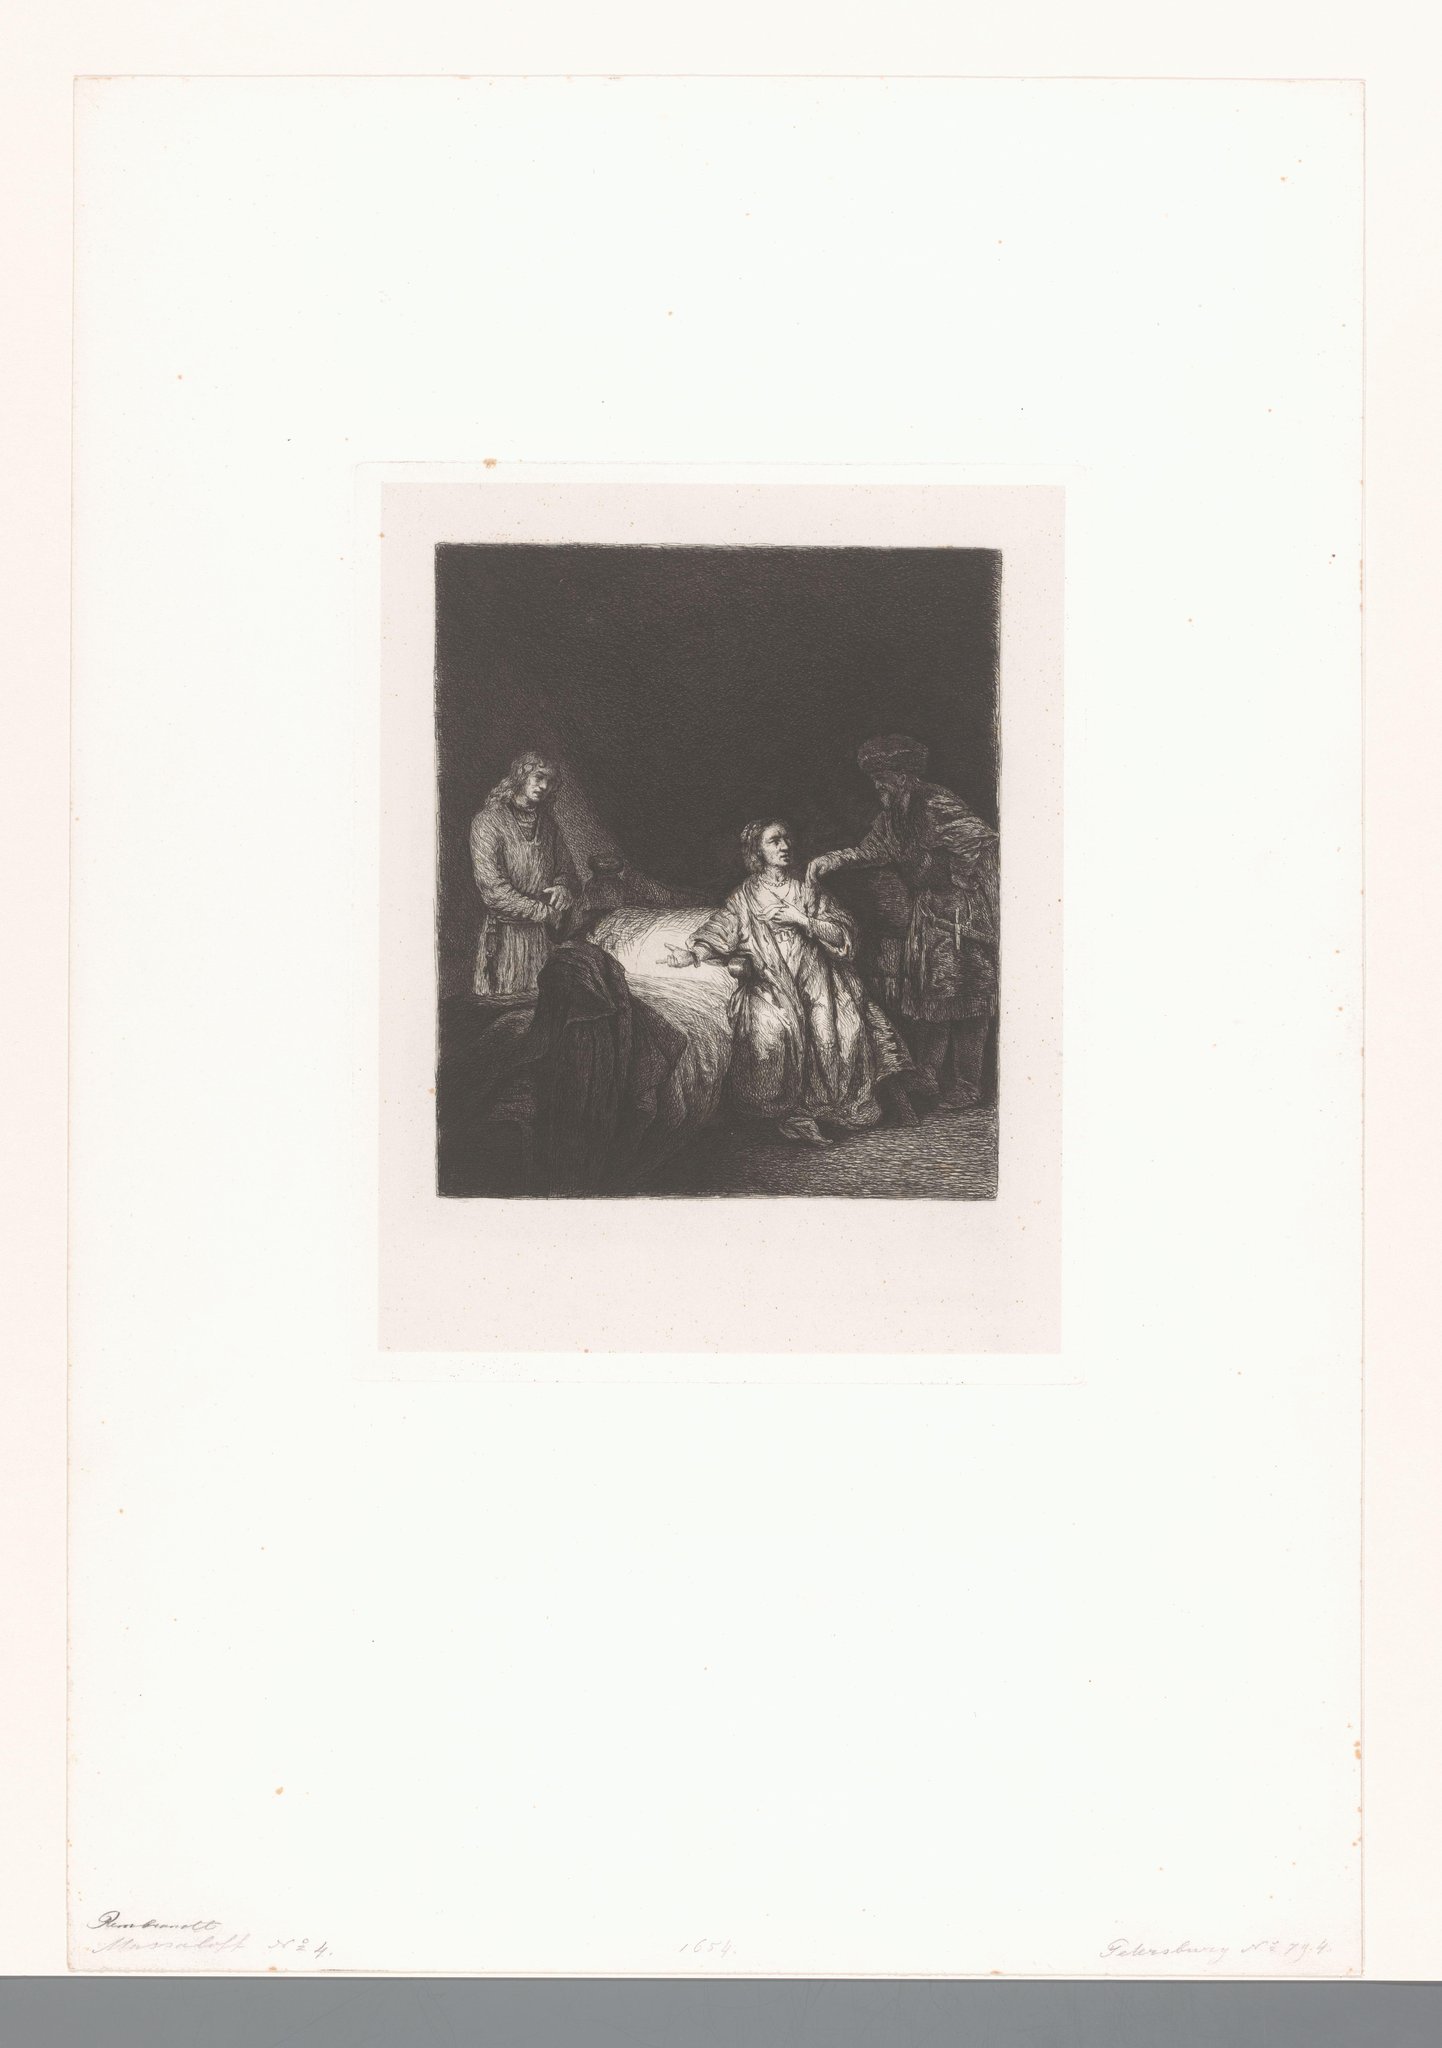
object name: print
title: Jonge vrouw wijst oude man op bed, waar een jonge man achter staat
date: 1857-1914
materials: paper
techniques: drypoint, etching, intaglio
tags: bed, bedroom